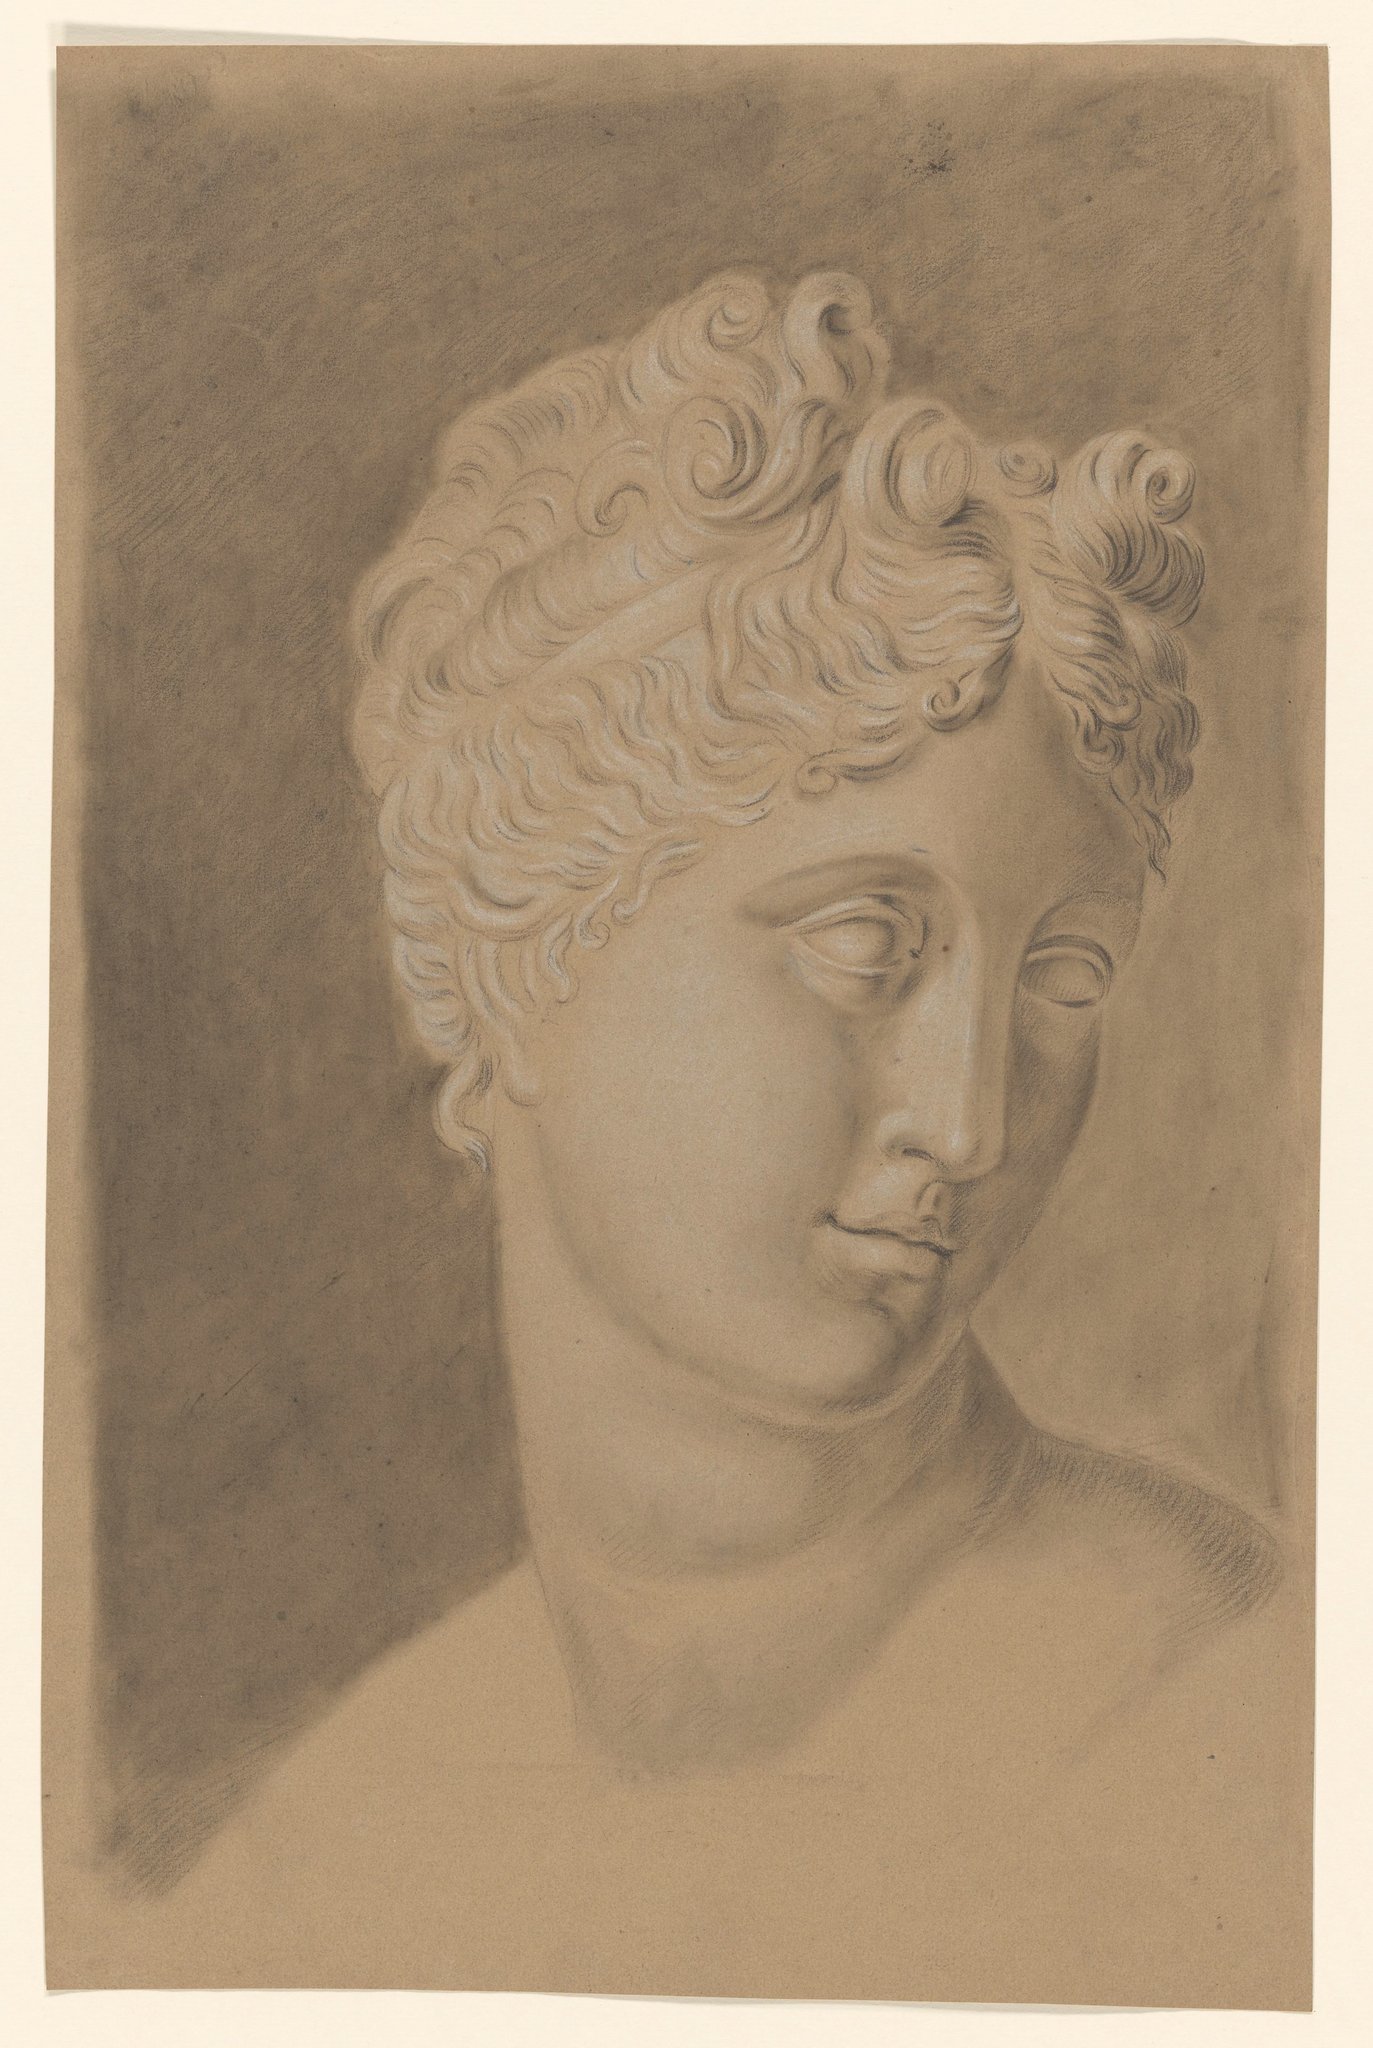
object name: drawing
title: Academiestudie naar een gips van een antiek beeld: buste van een vrouw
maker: johannes tavenraat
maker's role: draughtsman, painter, print maker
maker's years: 1809-1881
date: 1819-1881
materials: chalk, paper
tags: piece of sculpture, reproduction of a piece of sculpture (+ ceramics ~ arts)